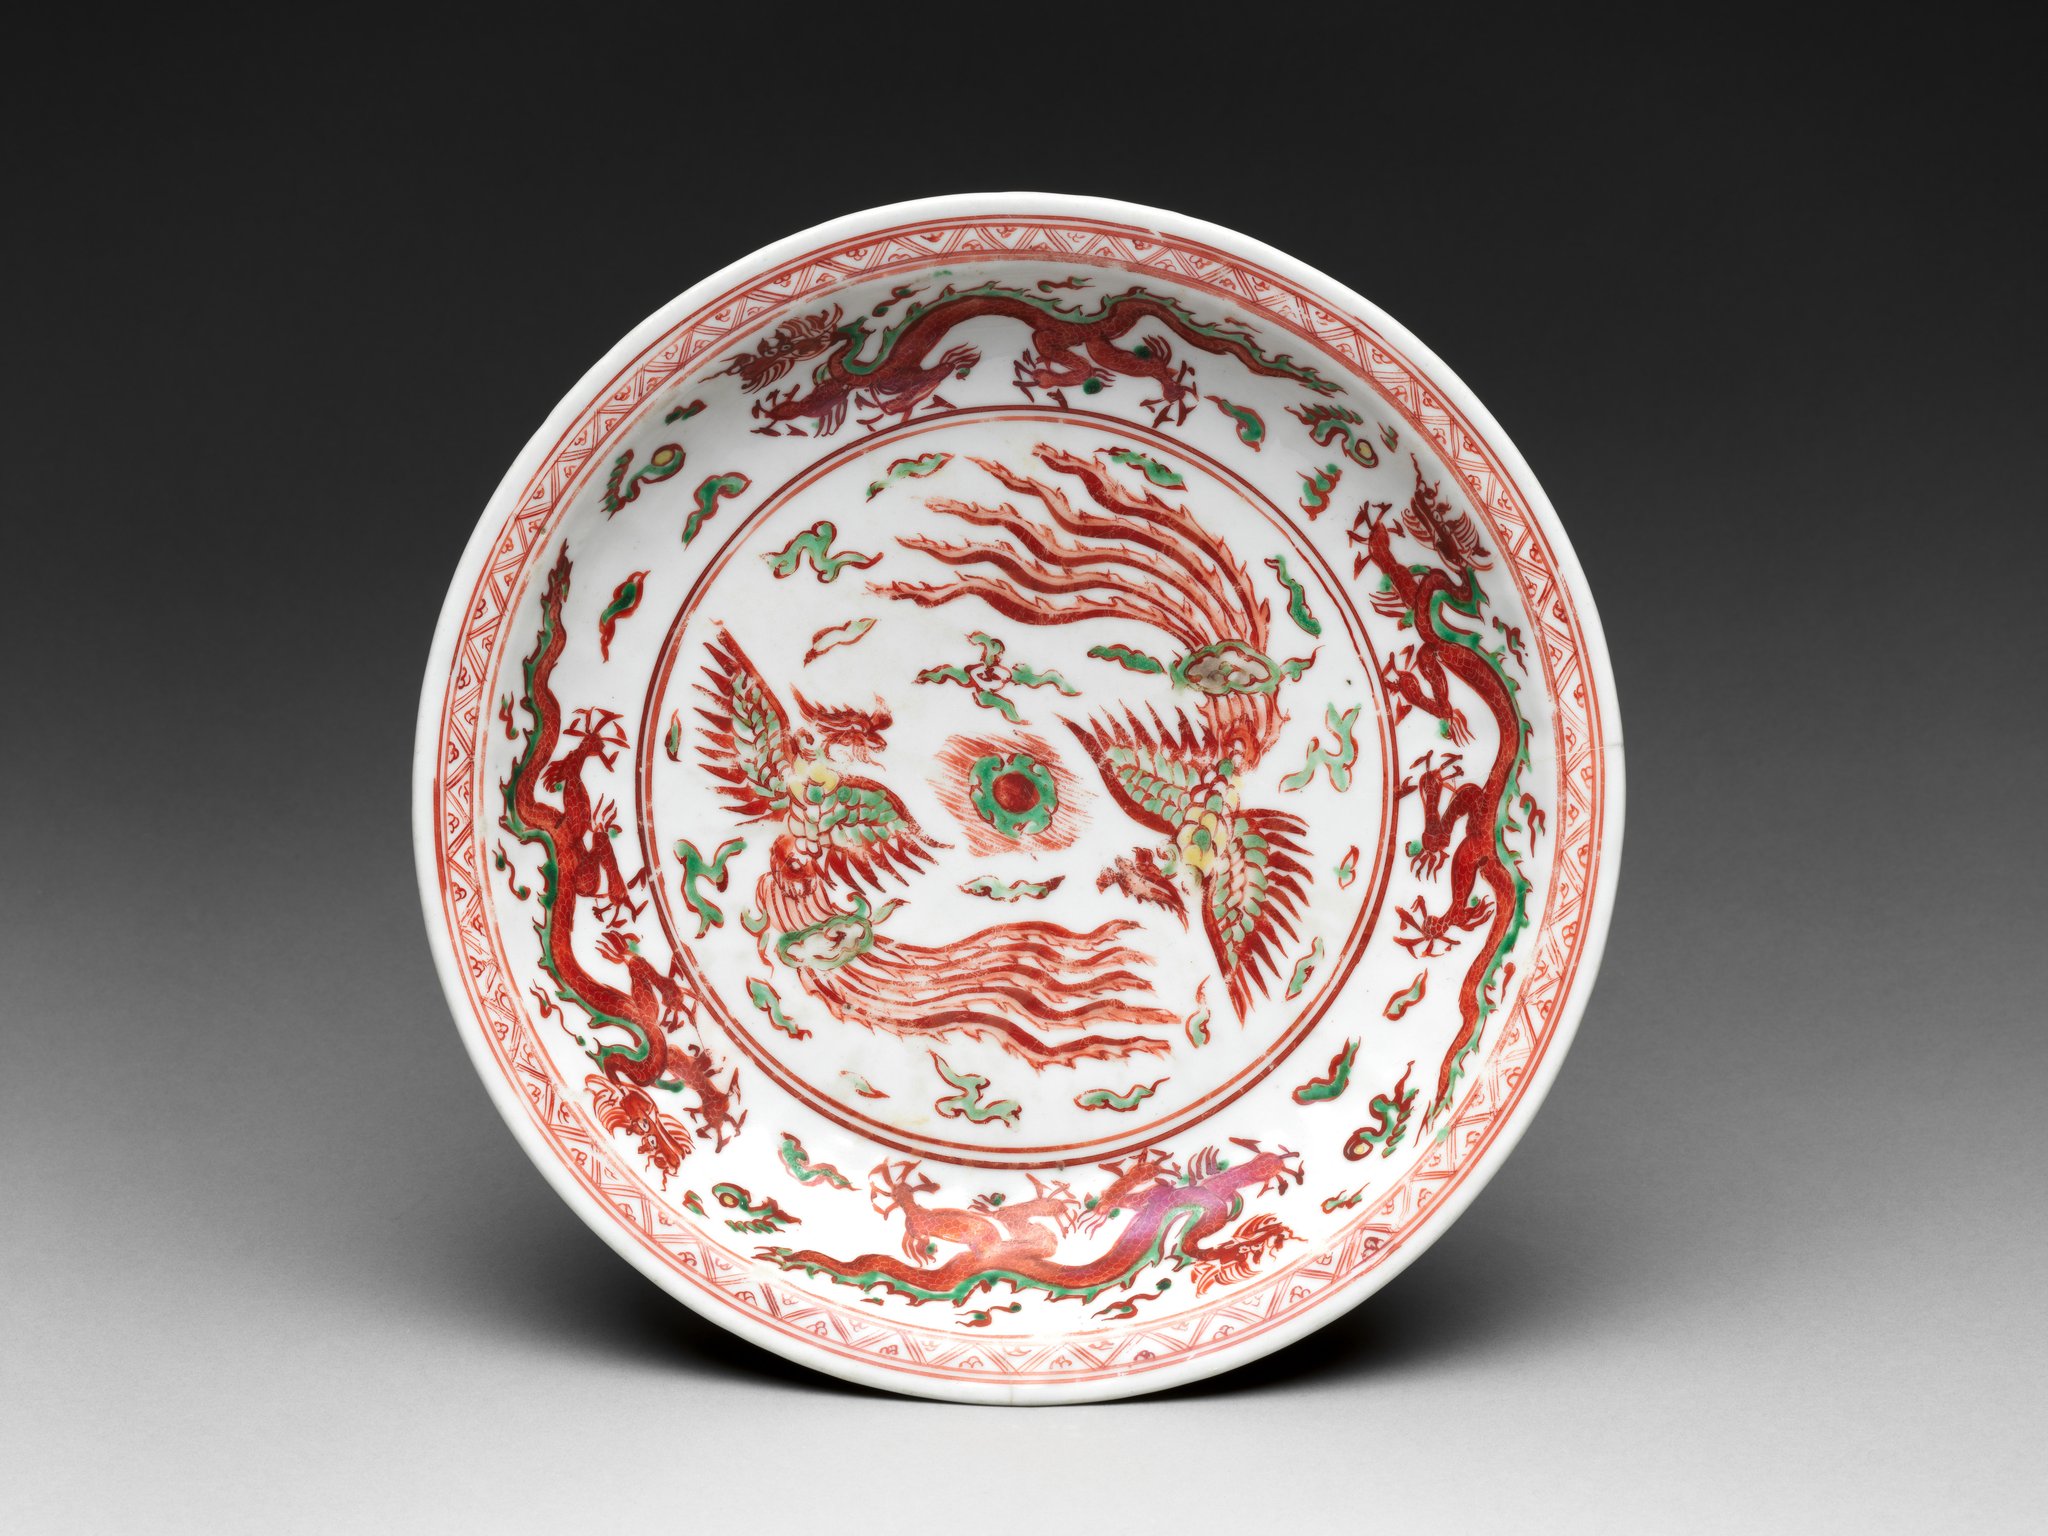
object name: dish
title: Dish with Phoenixes and Dragons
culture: chinese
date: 1501-1600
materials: enamel, glaze, porcelain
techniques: painting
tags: dragons